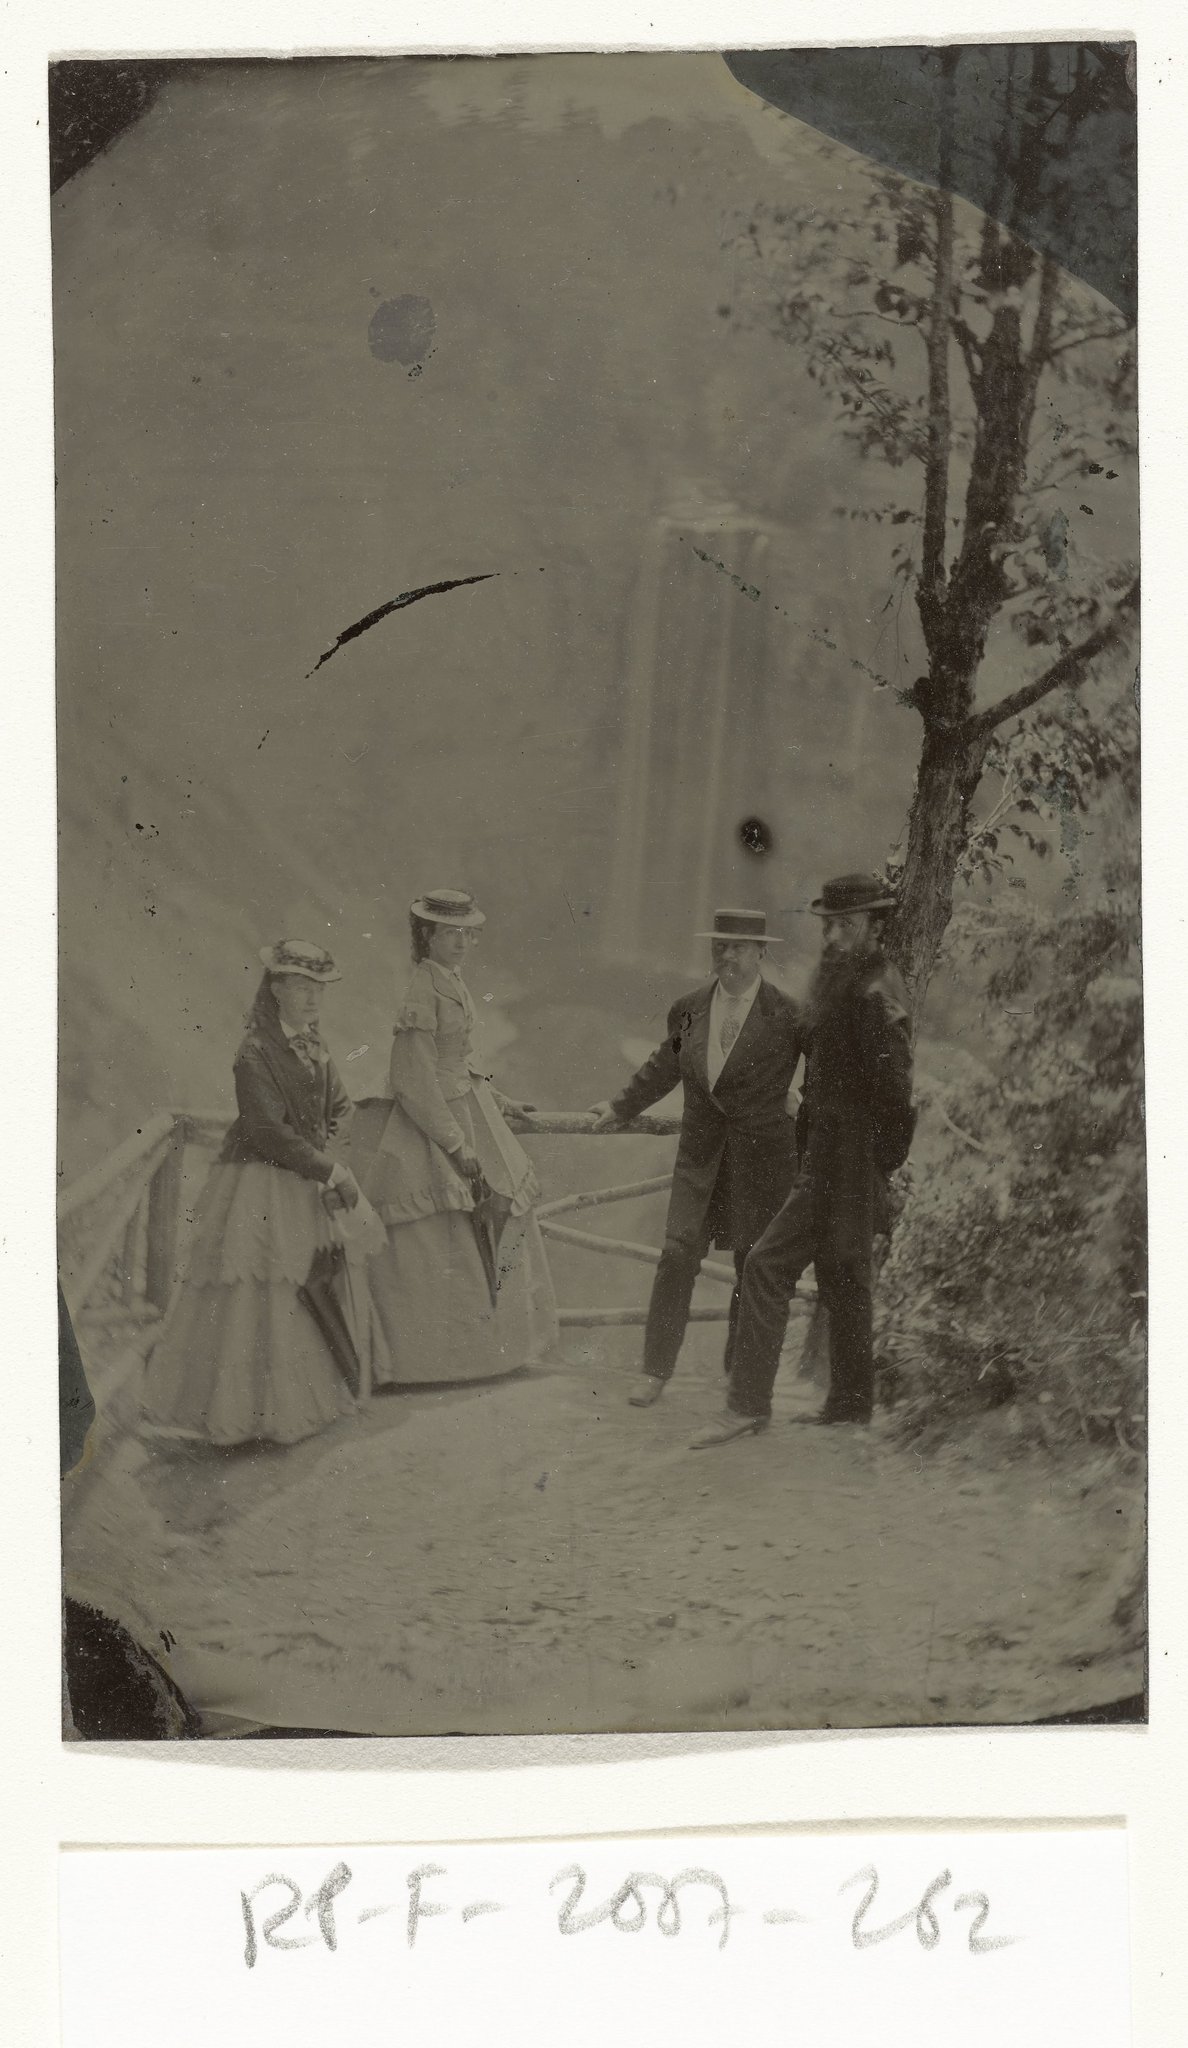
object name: photograph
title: Twee mannen en twee vrouwen staand op een zandpad, met op de achtergrond een waterval (Taughannock Falls), NY, Verenigde Staten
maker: Anonymous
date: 1870-1900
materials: metal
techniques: ferrotyping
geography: united states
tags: taughannock falls